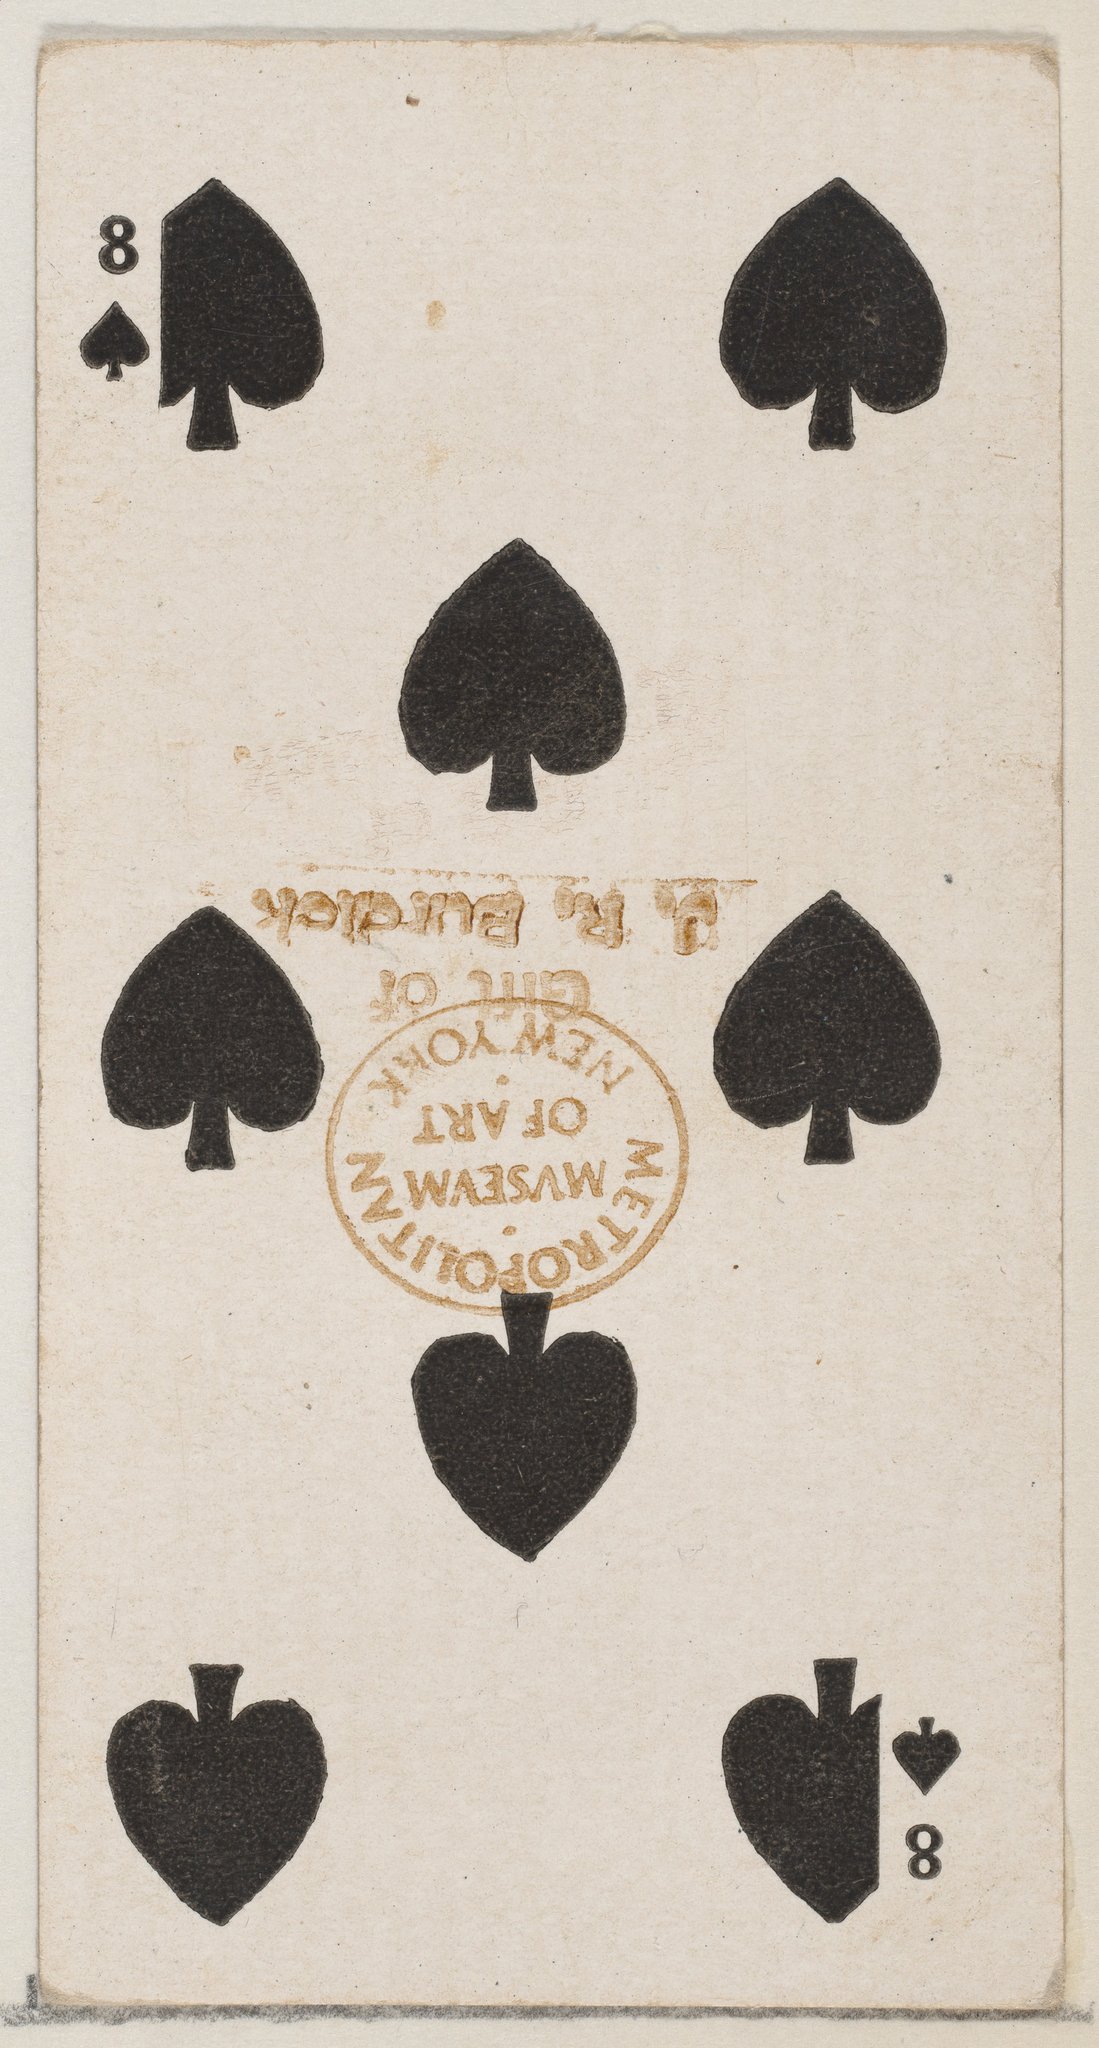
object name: print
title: Eight Spades (black), from the Playing Cards series (N84) for Duke brand cigarettes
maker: w. duke, sons & co.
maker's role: publisher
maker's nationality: american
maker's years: 1870-1920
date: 1888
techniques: color lithograph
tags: playing cards